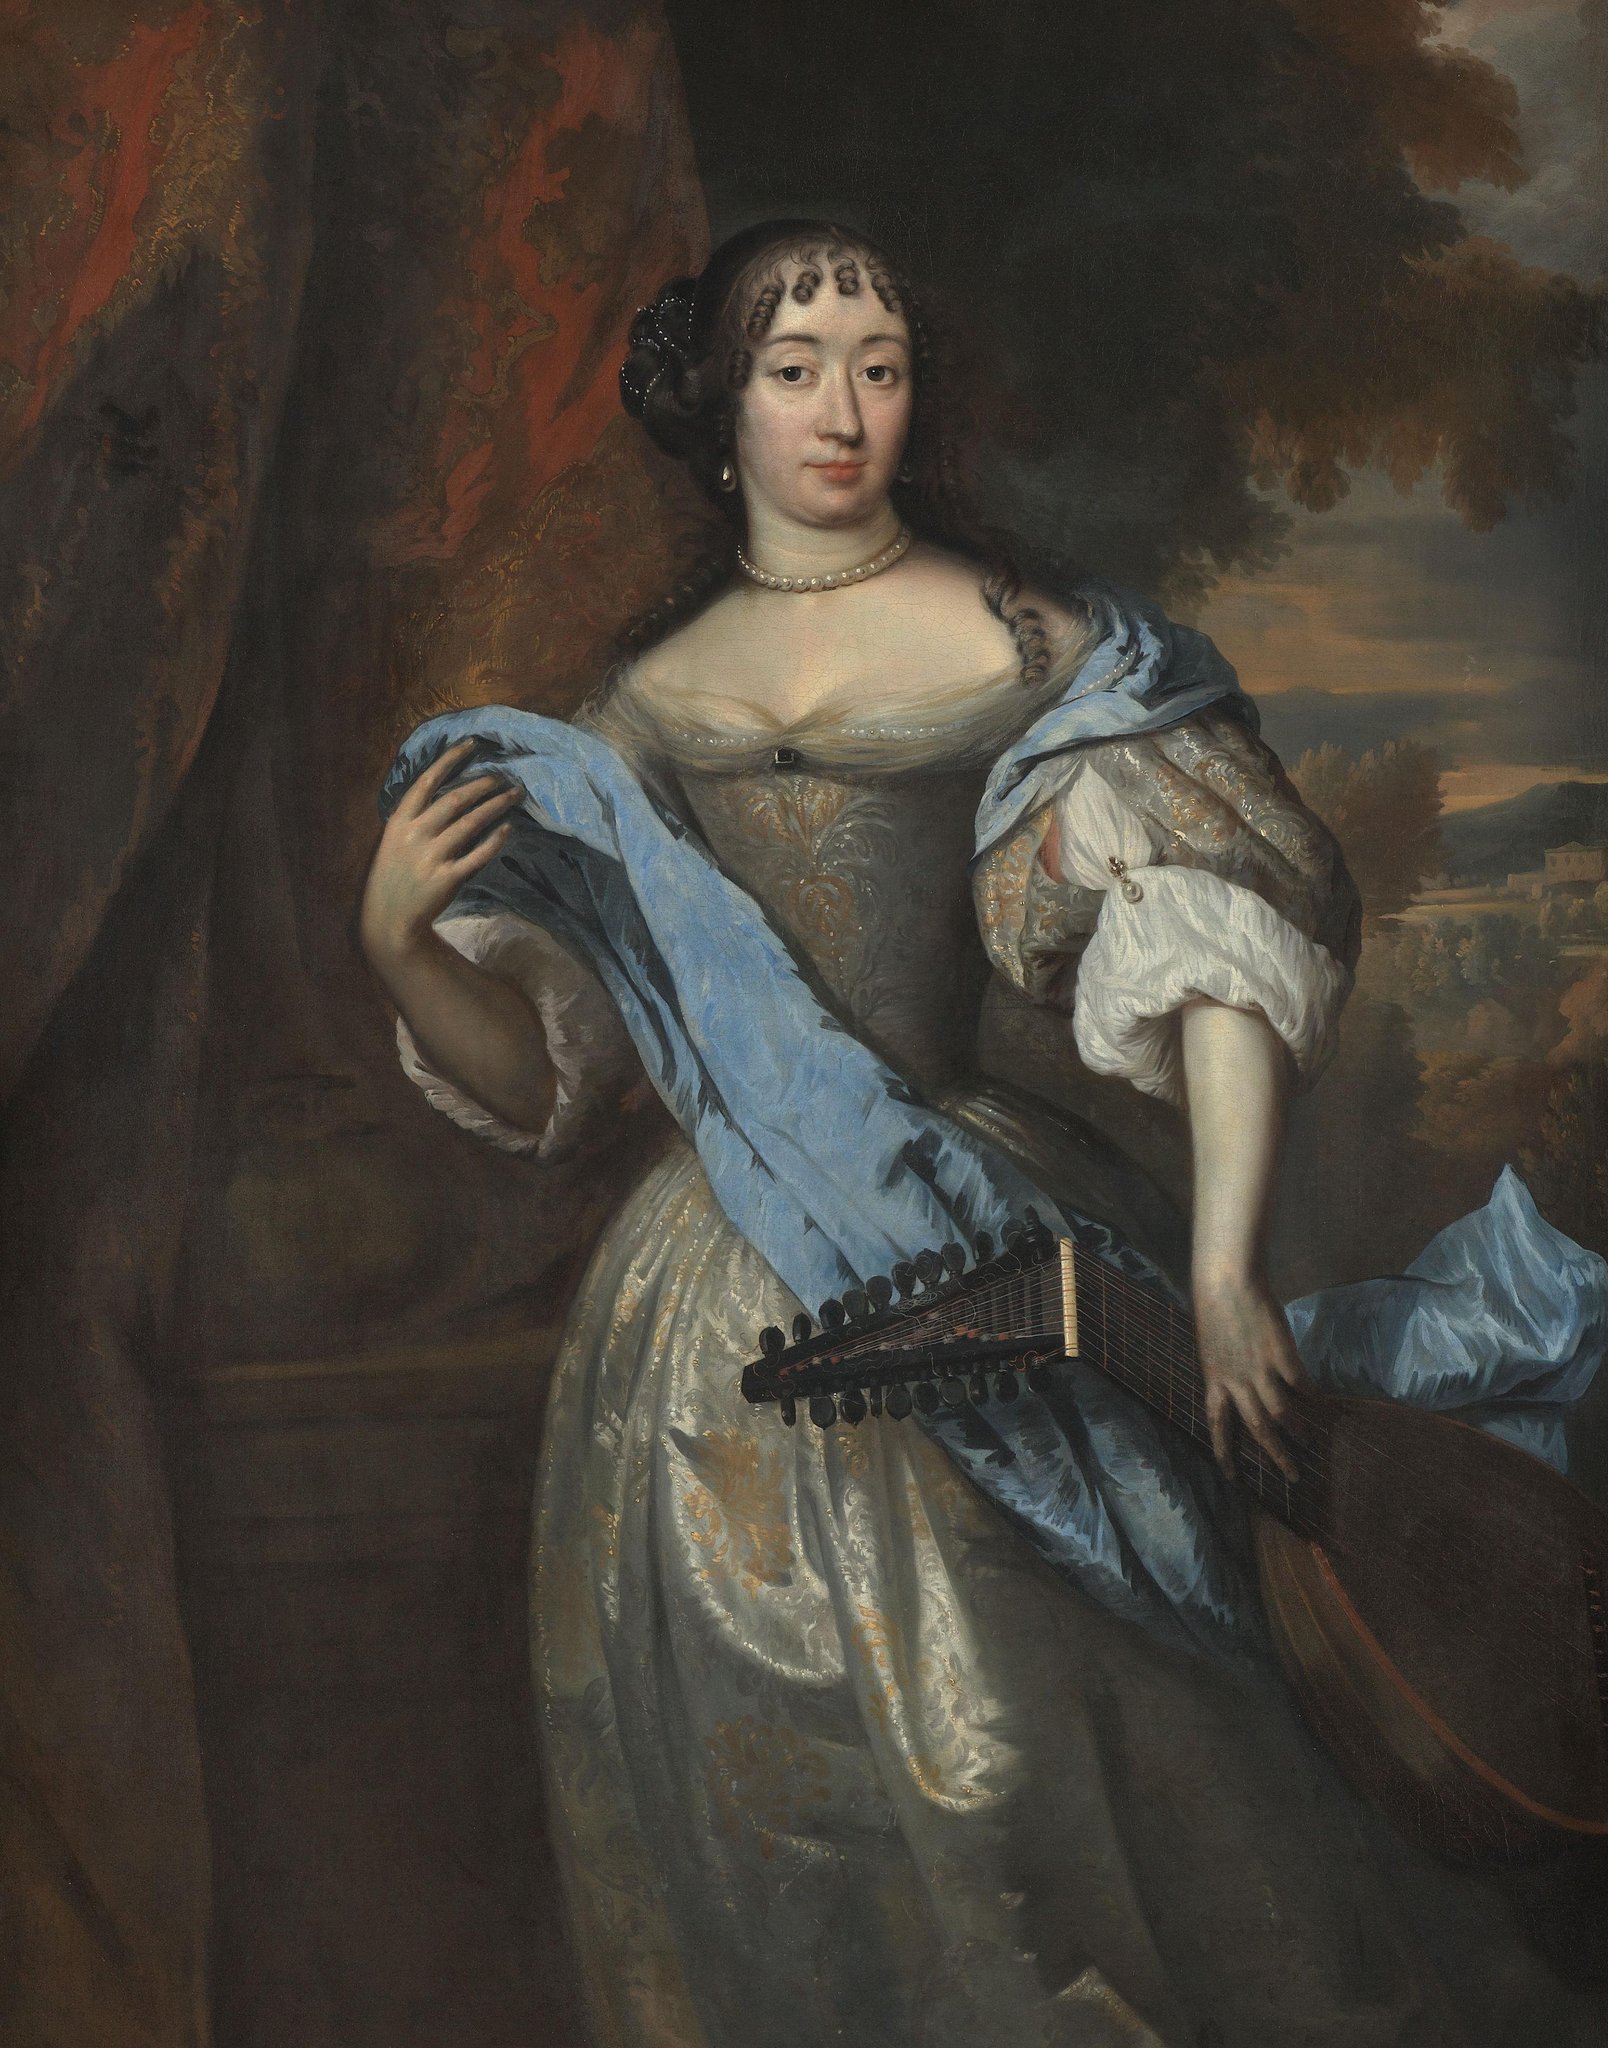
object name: painting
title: Johanna le Gillon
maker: jan de baen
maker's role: draughtsman, print maker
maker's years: 1633-1702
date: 1670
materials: canvas, oil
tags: amsterdam, historical persons - bb - woman, lute, and special forms of lute, e.g.: theorbo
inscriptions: signature: ‘J. de Baen f.’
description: Johanna le Gillon had herself portrayed holding a lute, her favourite instrument, showcasing her exceptional musical talent. The famous composer Constantijn Huygens sent her all manner of musical pieces for the lute. The portrait is still in its original gilt limewood frame, lavishly adorned with putti (cherubs) collecting roses, lush golden vines, and garlands. The fitting motto in the cartouche at the bottom reads: ‘A contented heart leads to great talent’.